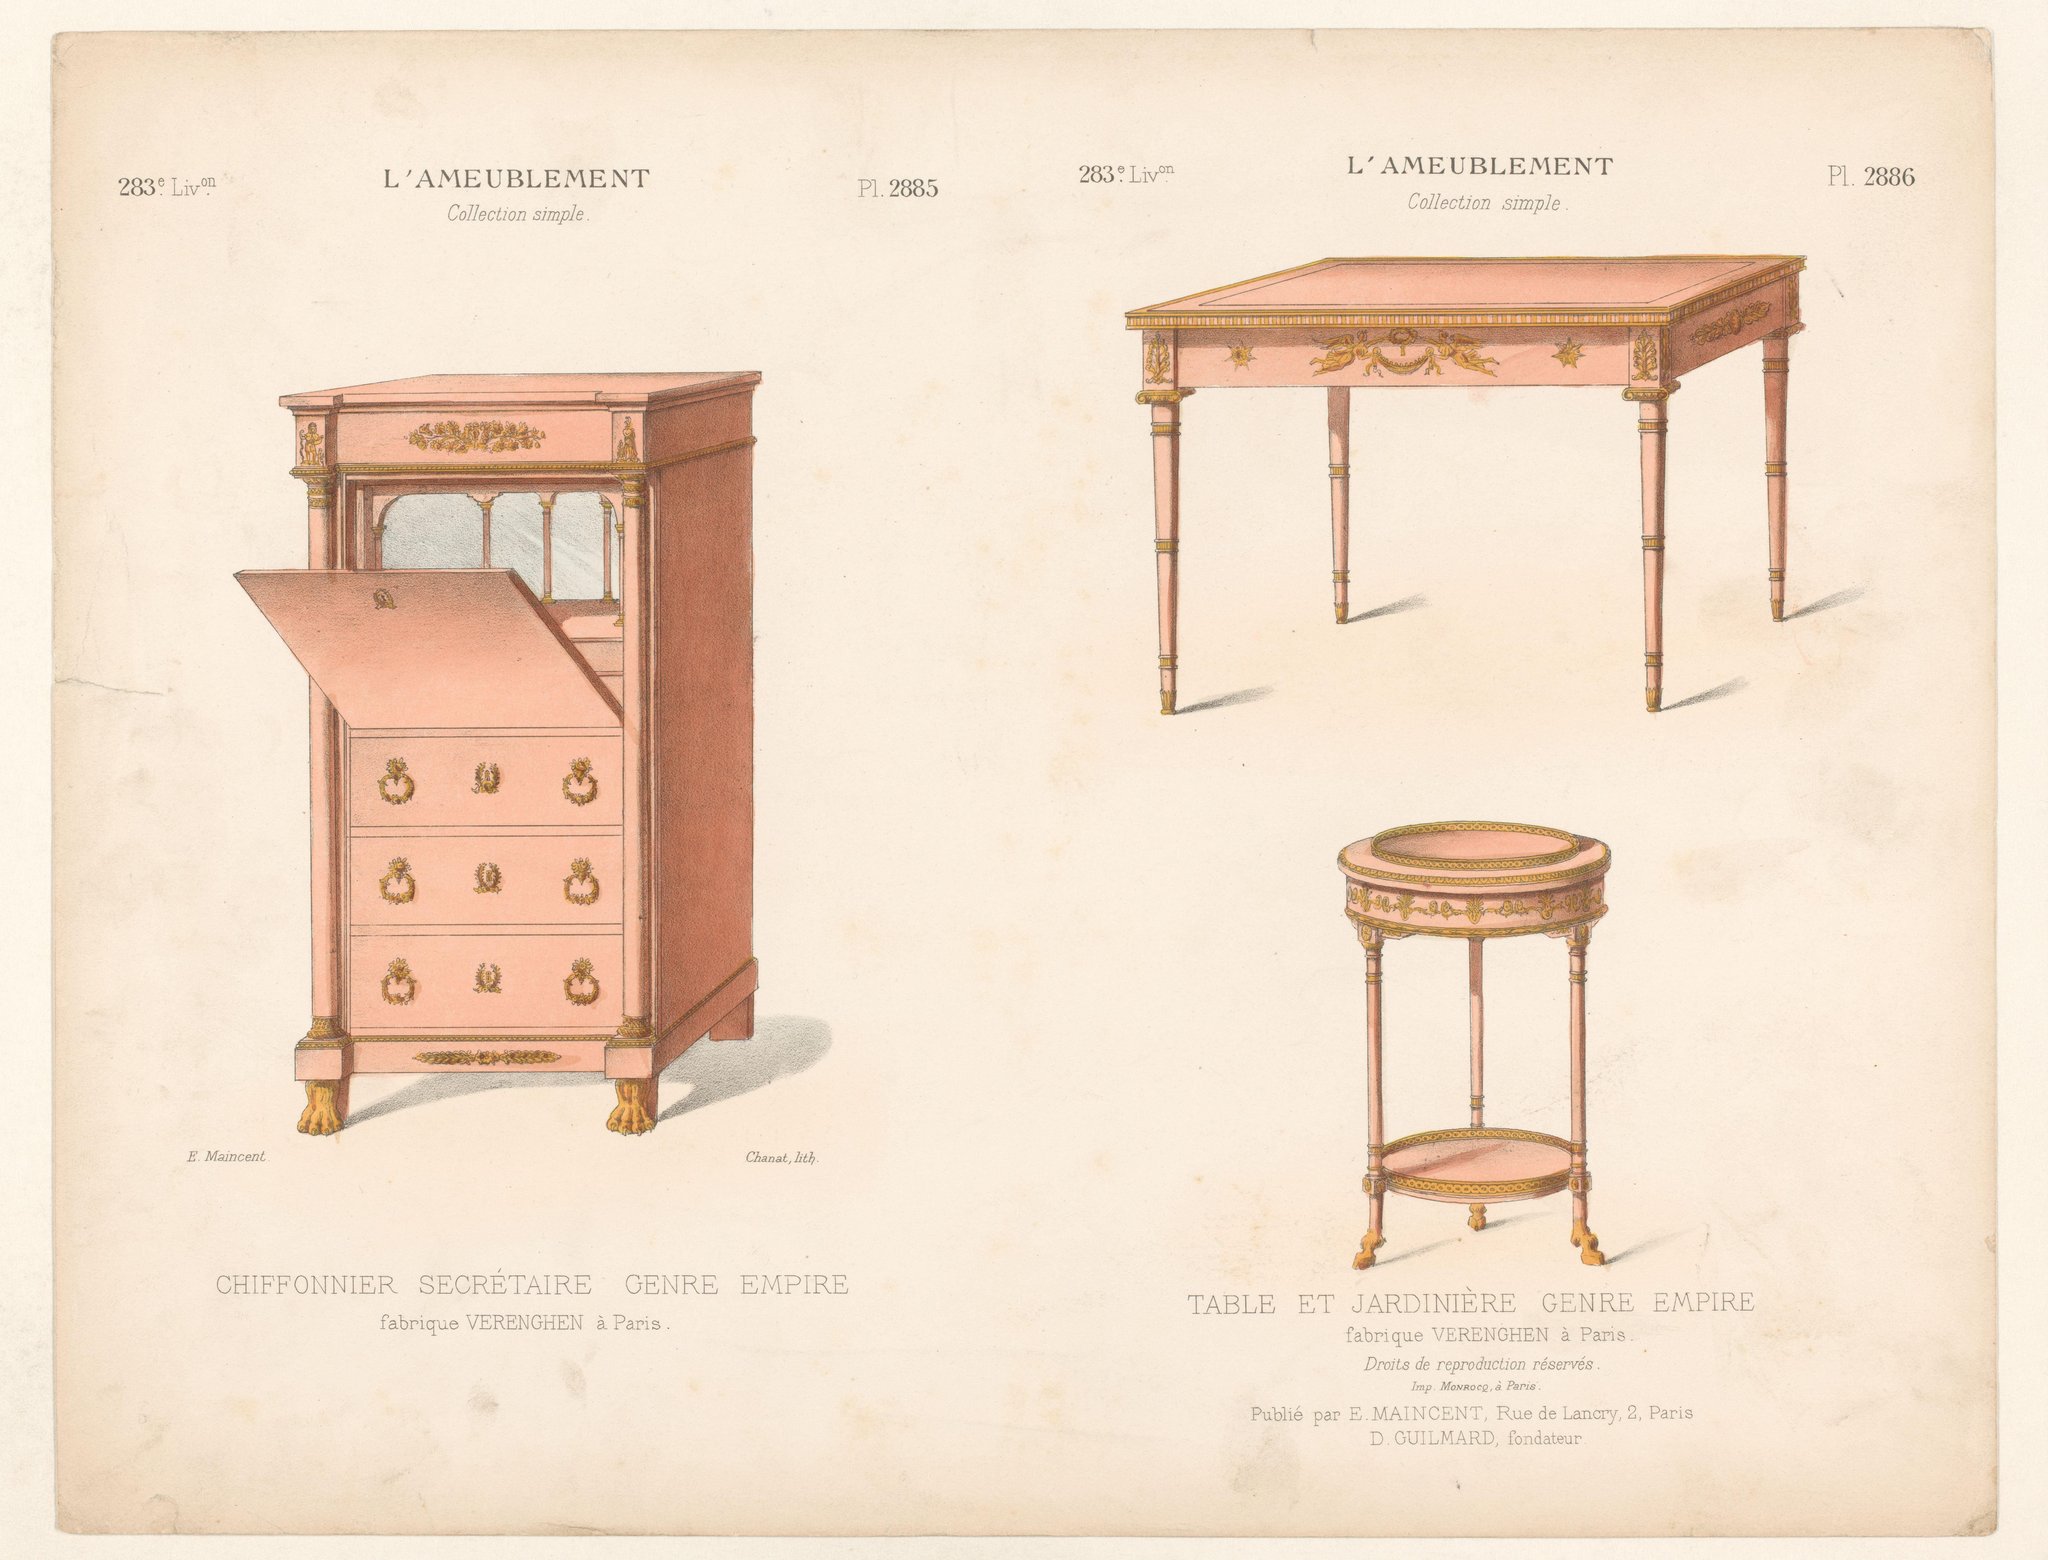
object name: print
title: Chiffonnier secrétaire genre empire / Table et jardinière genre empire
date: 1885-1895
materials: paper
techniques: hand coloring, lithograph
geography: paris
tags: furniture for storage, table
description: Een secretaire, rechthoekige tafel en jardinière in de empirestijl. Prent uit 283e Livraison.